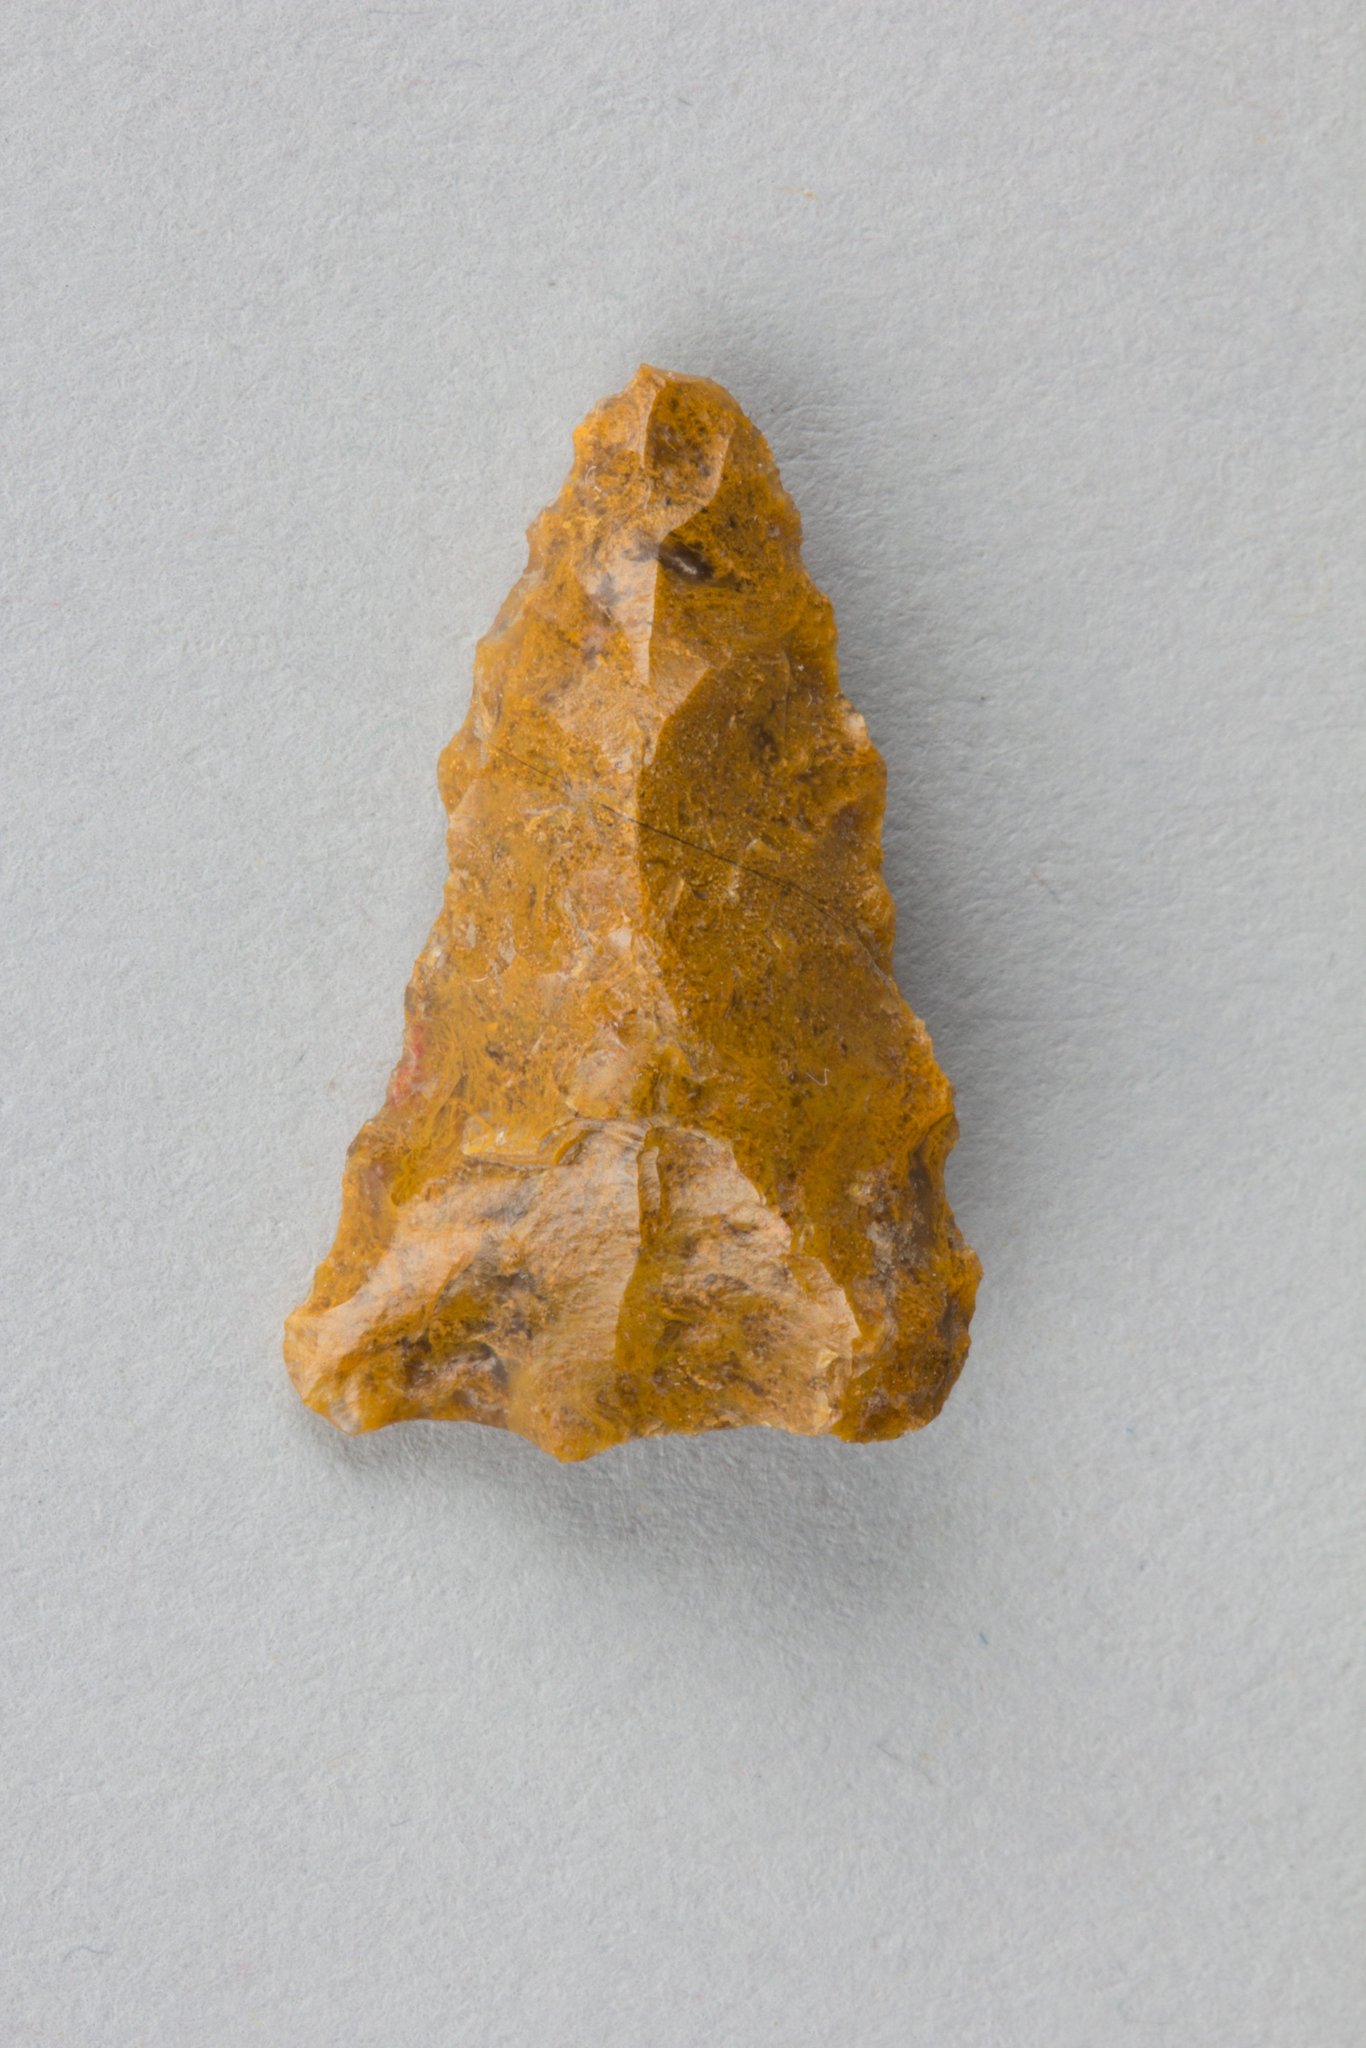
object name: arrowhead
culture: japanese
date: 1500-1000 BCE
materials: stone